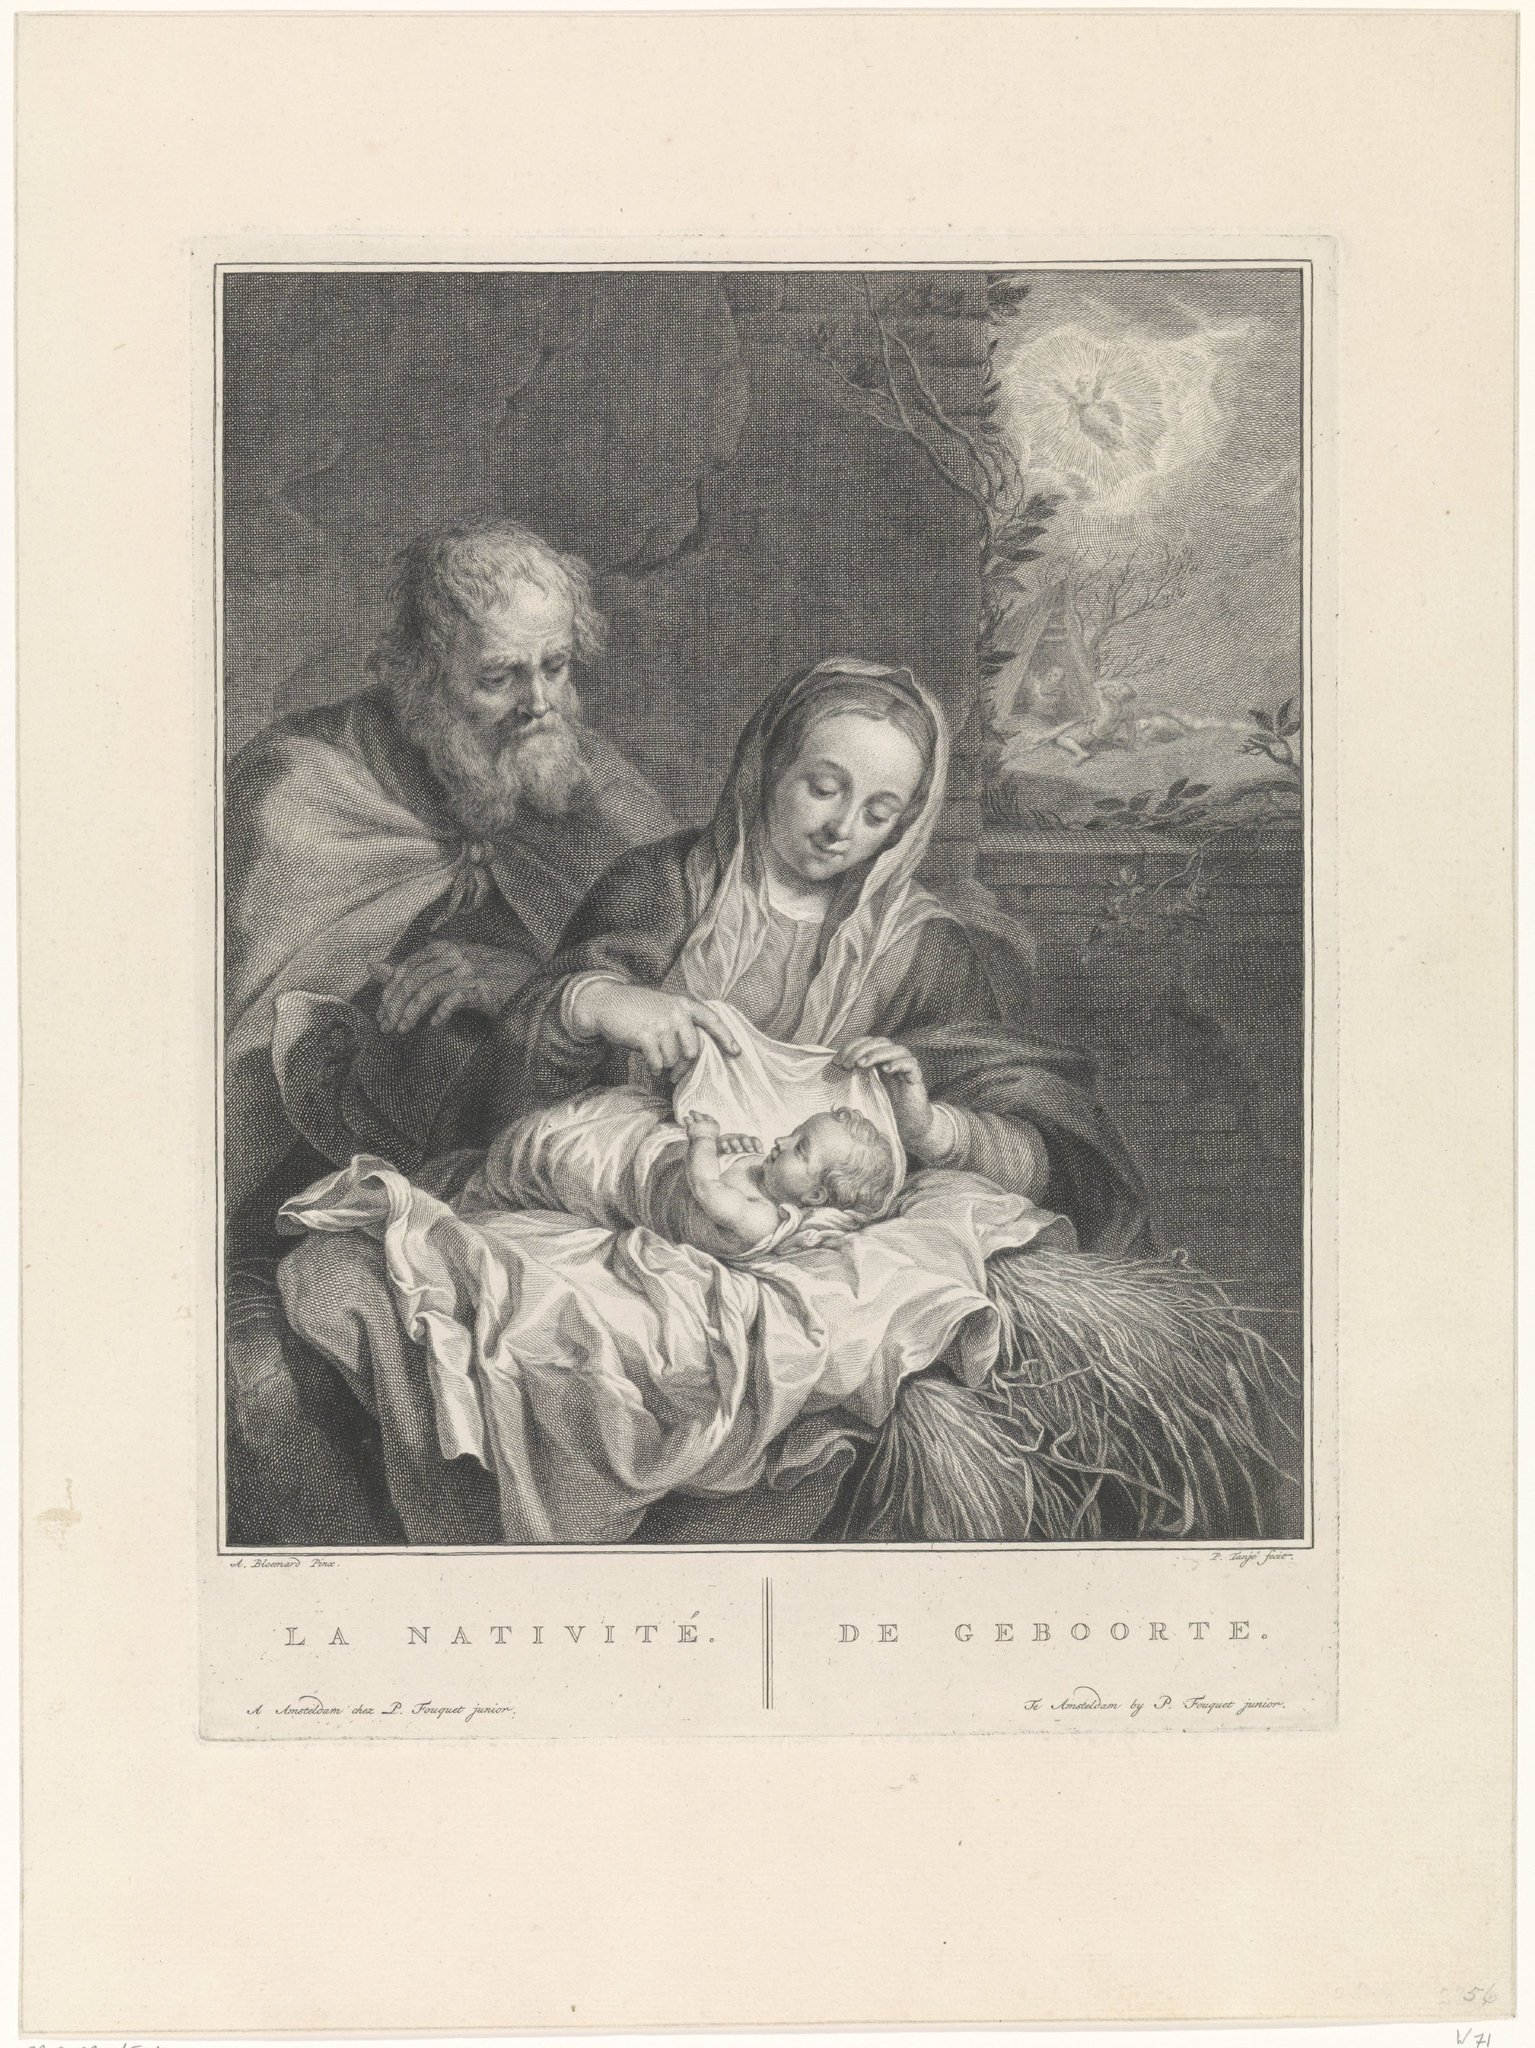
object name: print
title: Geboorte van Christus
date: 1760-1761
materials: paper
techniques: engraving, etching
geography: amsterdam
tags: annunciation of christ's birth to the shepherds (and/or shepherdesses) at night; a host of singing angels in the air, mary, joseph and the new-born christ (nativity)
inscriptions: collector's mark: Lugt 240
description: Maria en Jozef zitten bij de pasgeboren Christus. Rechtsachter de verkondiging aan de herders.